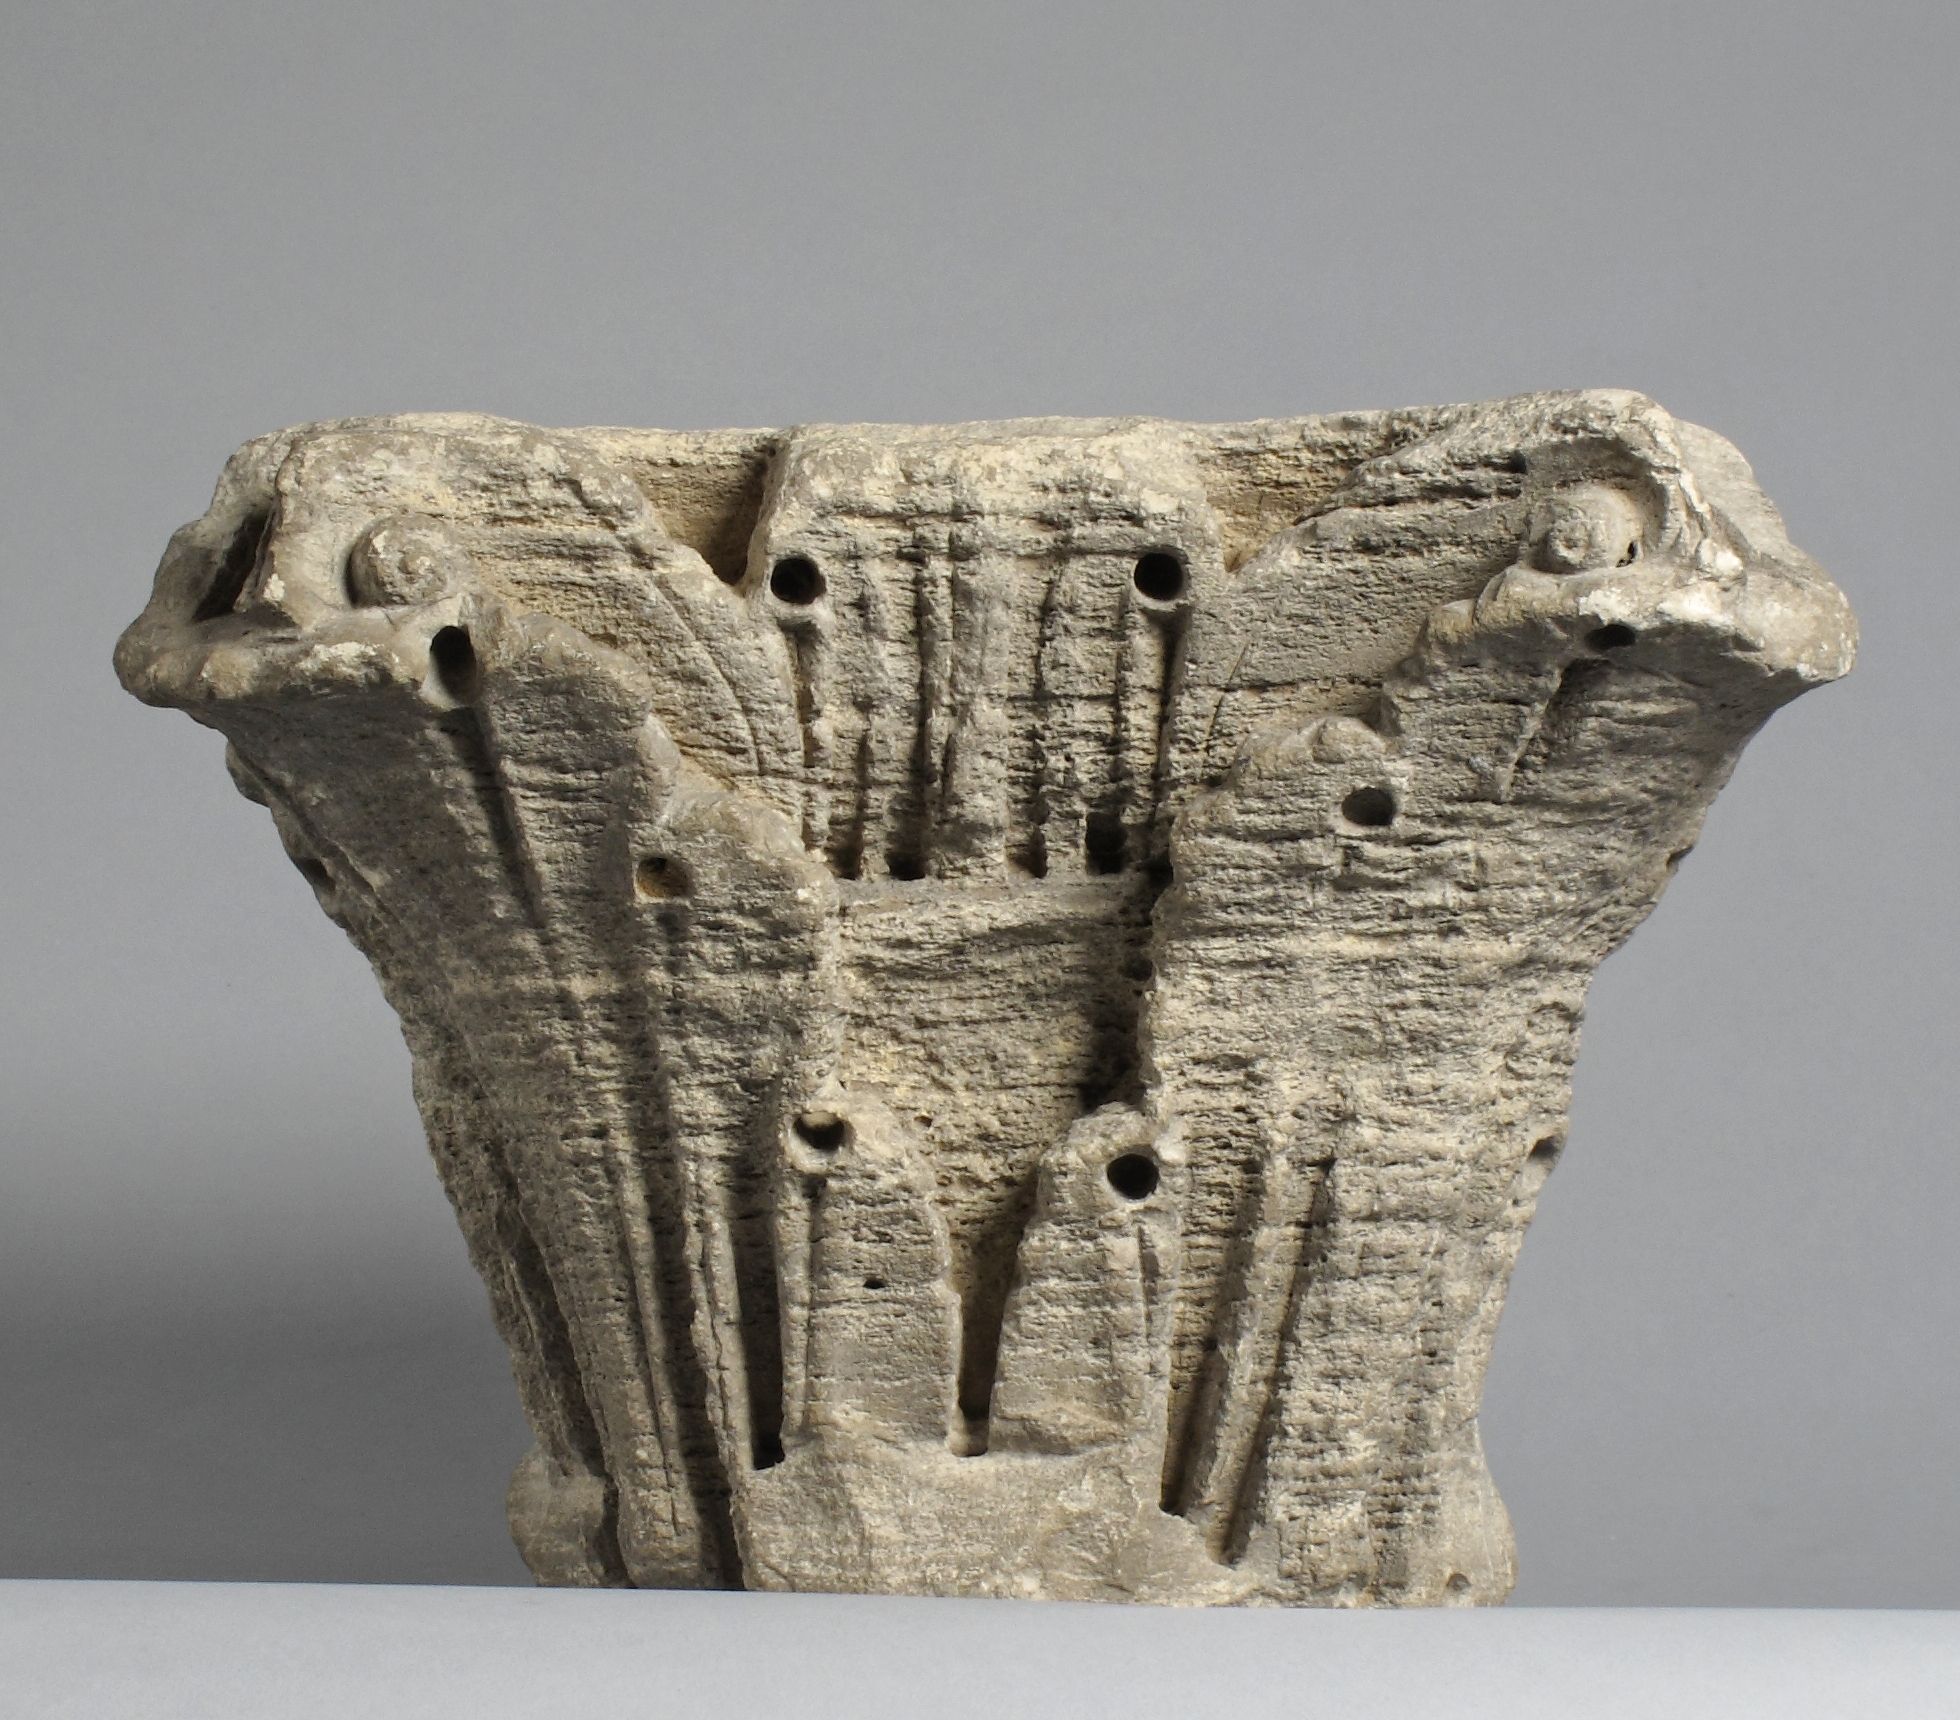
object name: capital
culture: french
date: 1167-1200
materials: stone